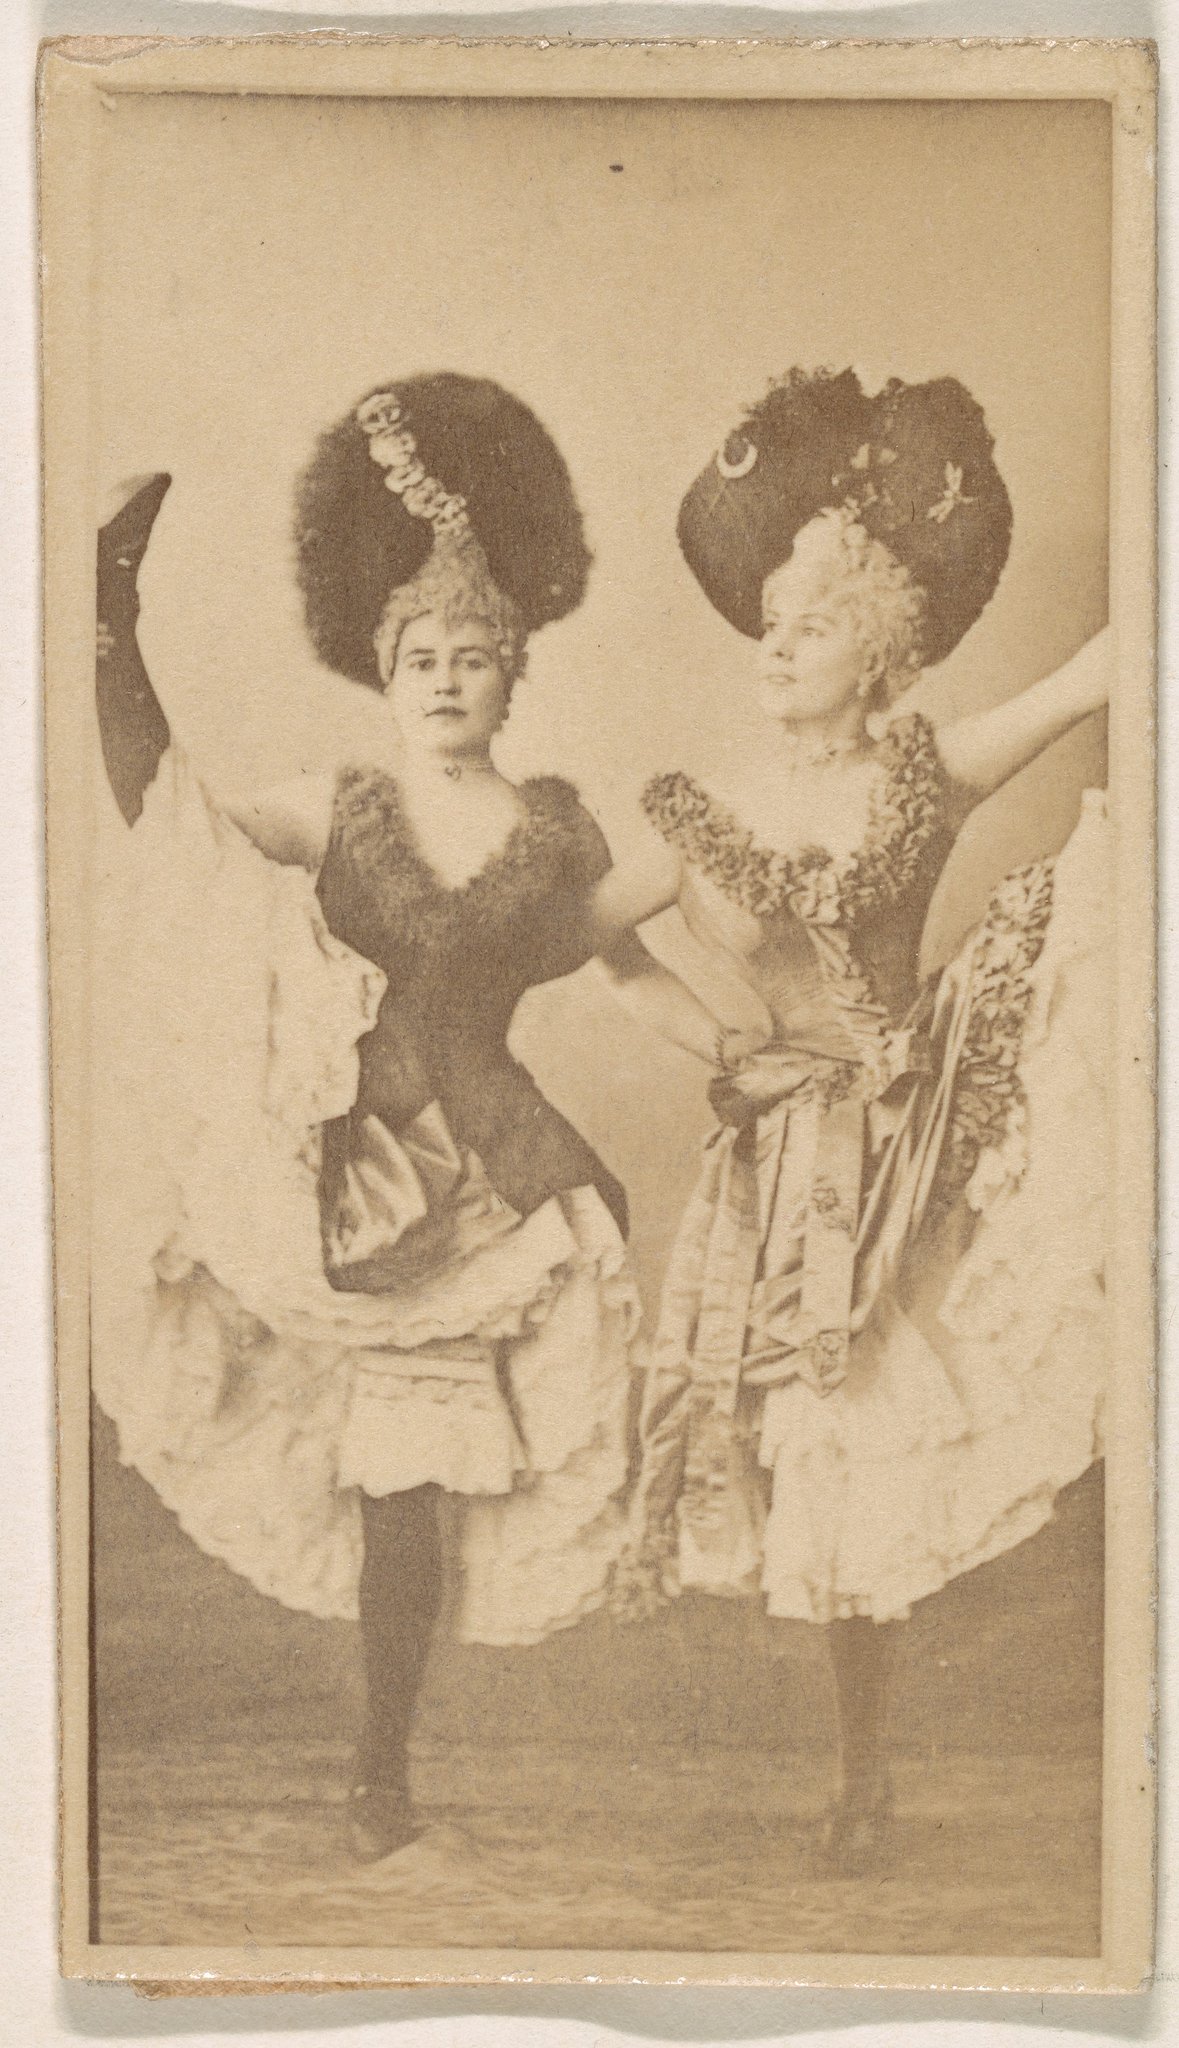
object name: photograph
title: Two dancers with high kick, from the Actresses series (N245) issued by Kinney Brothers to promote Sweet Caporal Cigarettes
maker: kinney brothers tobacco company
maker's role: publisher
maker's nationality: american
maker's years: 1869-2011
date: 1890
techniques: albumen silver print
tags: portraits,women,dancers